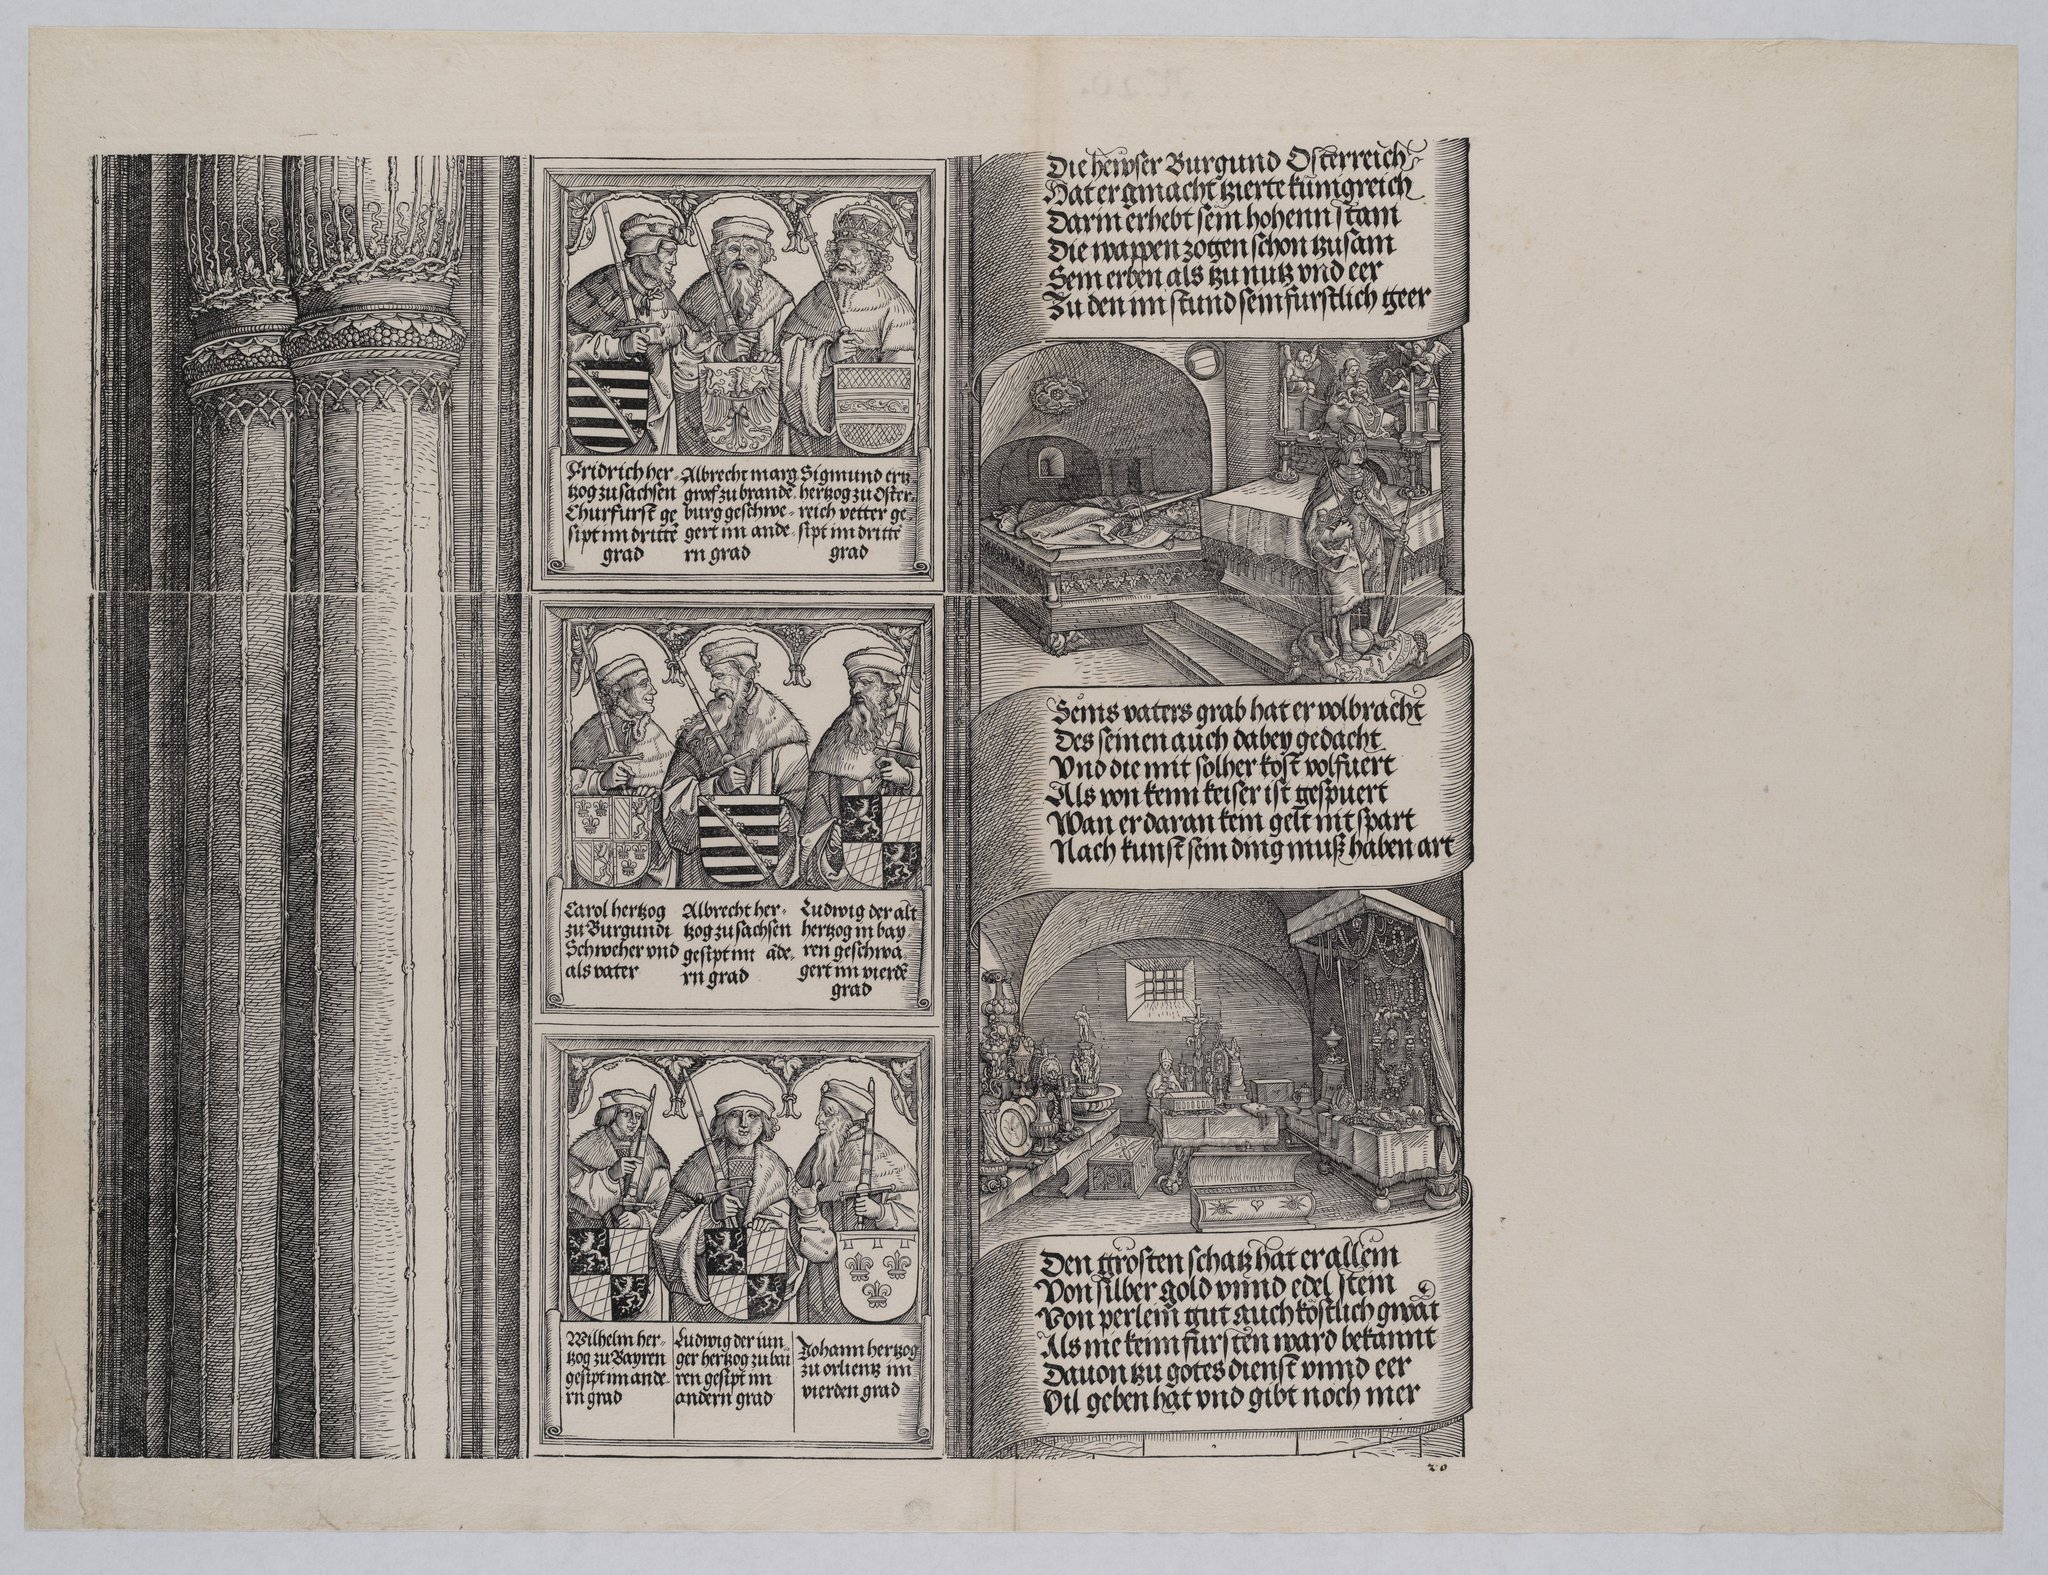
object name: print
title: The Tomb Erected by Maximilian for His Father; and The Imperial Treasure; with Portraits of Maximilian's Ancestors and Relatives, from the Arch of Honor, proof, dated 1515, printed 1517-18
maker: albrecht dürer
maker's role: artist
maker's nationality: german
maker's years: 1471-1528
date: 1515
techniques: letterpress, woodcut